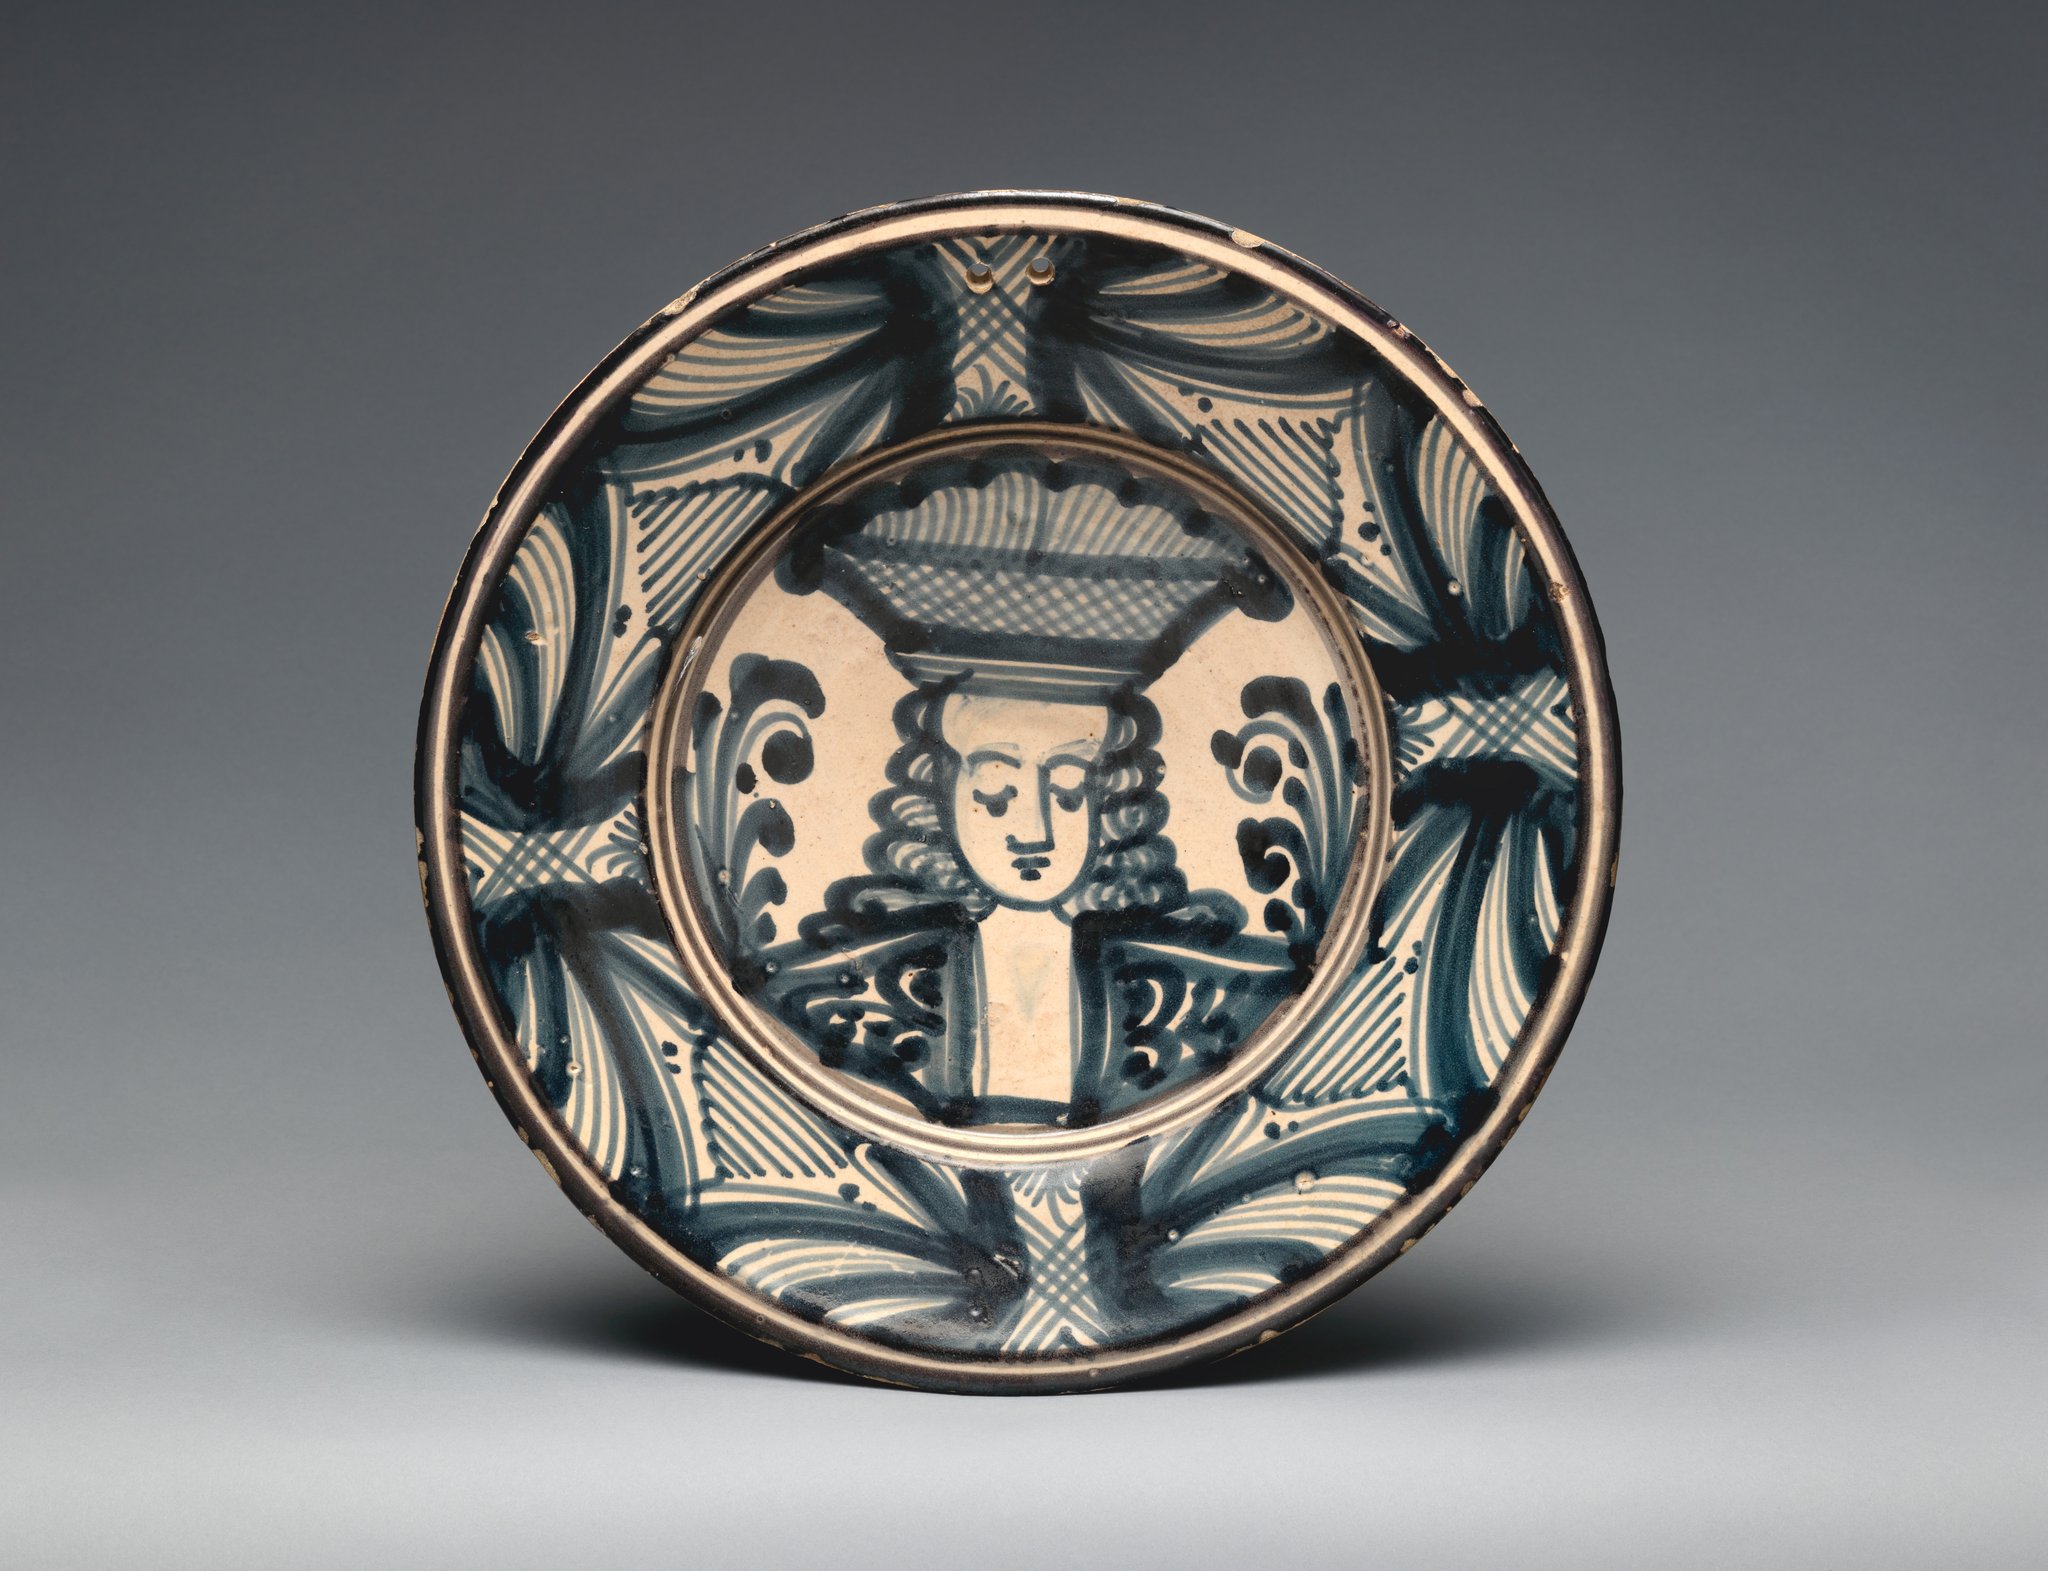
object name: charger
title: Charger with portrait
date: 1667-1700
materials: earthenware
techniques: glazing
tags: men,portraits